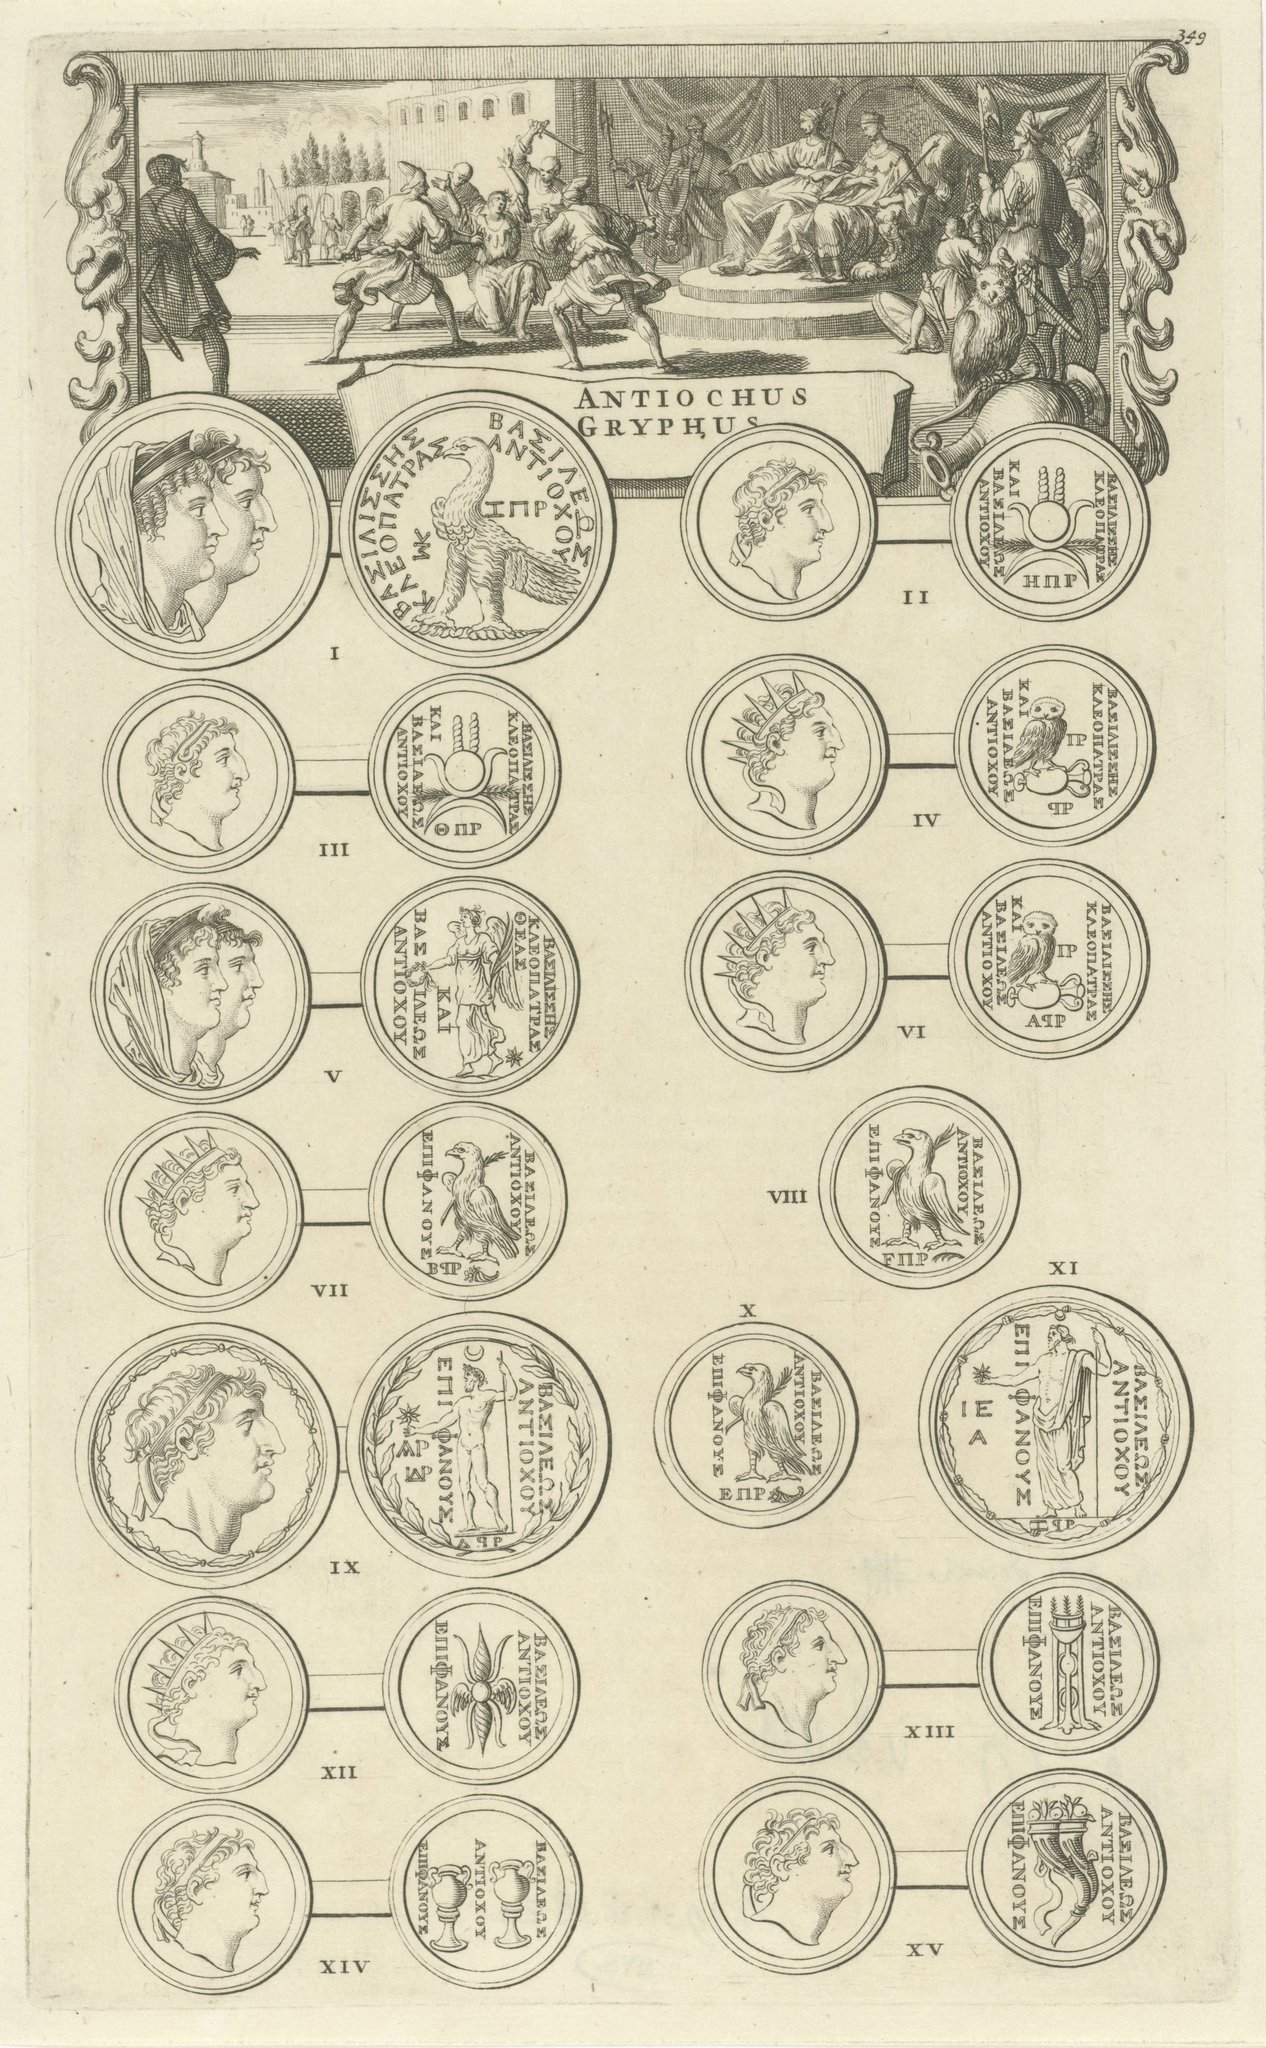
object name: print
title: Antiochus Gryphus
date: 1690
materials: paper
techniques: etching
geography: amsterdam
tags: medal (considered as a piece of sculpture, regardless of its specific function), violent death, being killed; being mishandled and maltreated; seeking death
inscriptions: collector's mark: Lugt 2228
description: Illustratie opgenomen in: Goeree, Wilhelmus. Voor-bereidselen tot de bybelsche wysheid, en gebruik der heilige en kerklijke historien, 3 delen. Amsterdam: Wilhelmus Goeree I, 1690, dl. I.